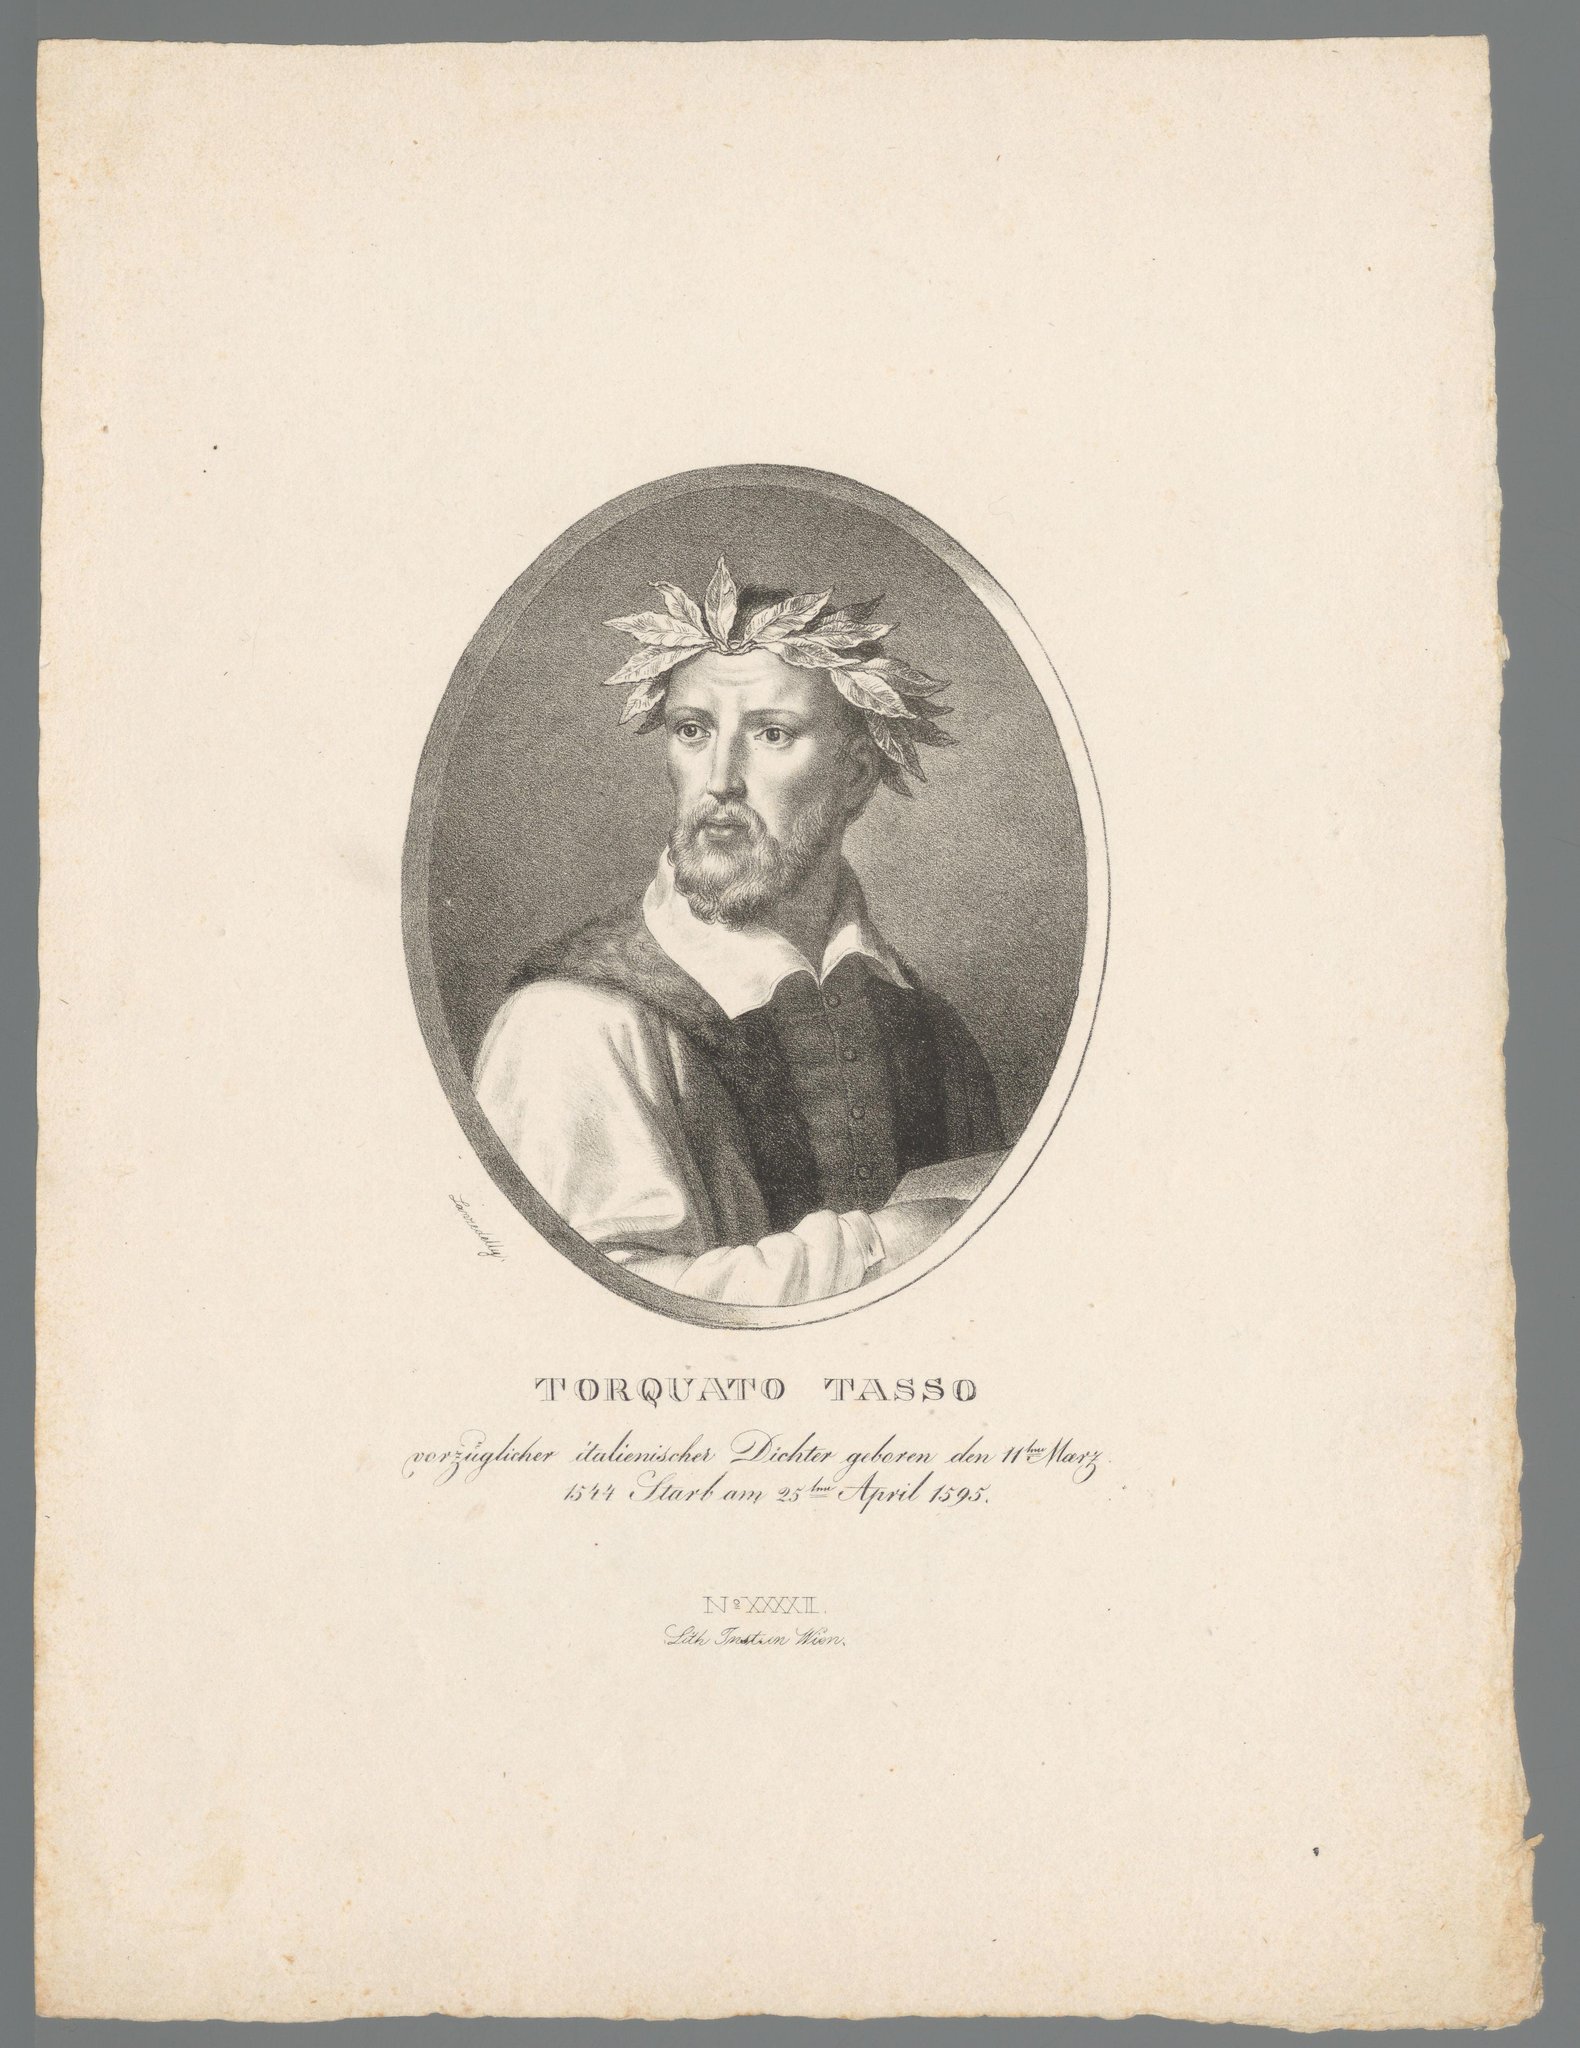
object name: print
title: Torquato Tasso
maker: josef lanzedelly (il vecchio)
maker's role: print maker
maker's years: 1774-1832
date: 1784-1832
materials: paper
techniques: lithograph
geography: vienna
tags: rome, torquato tasso, historical persons, writer, poet, author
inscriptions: collector's mark: Lugt 2228